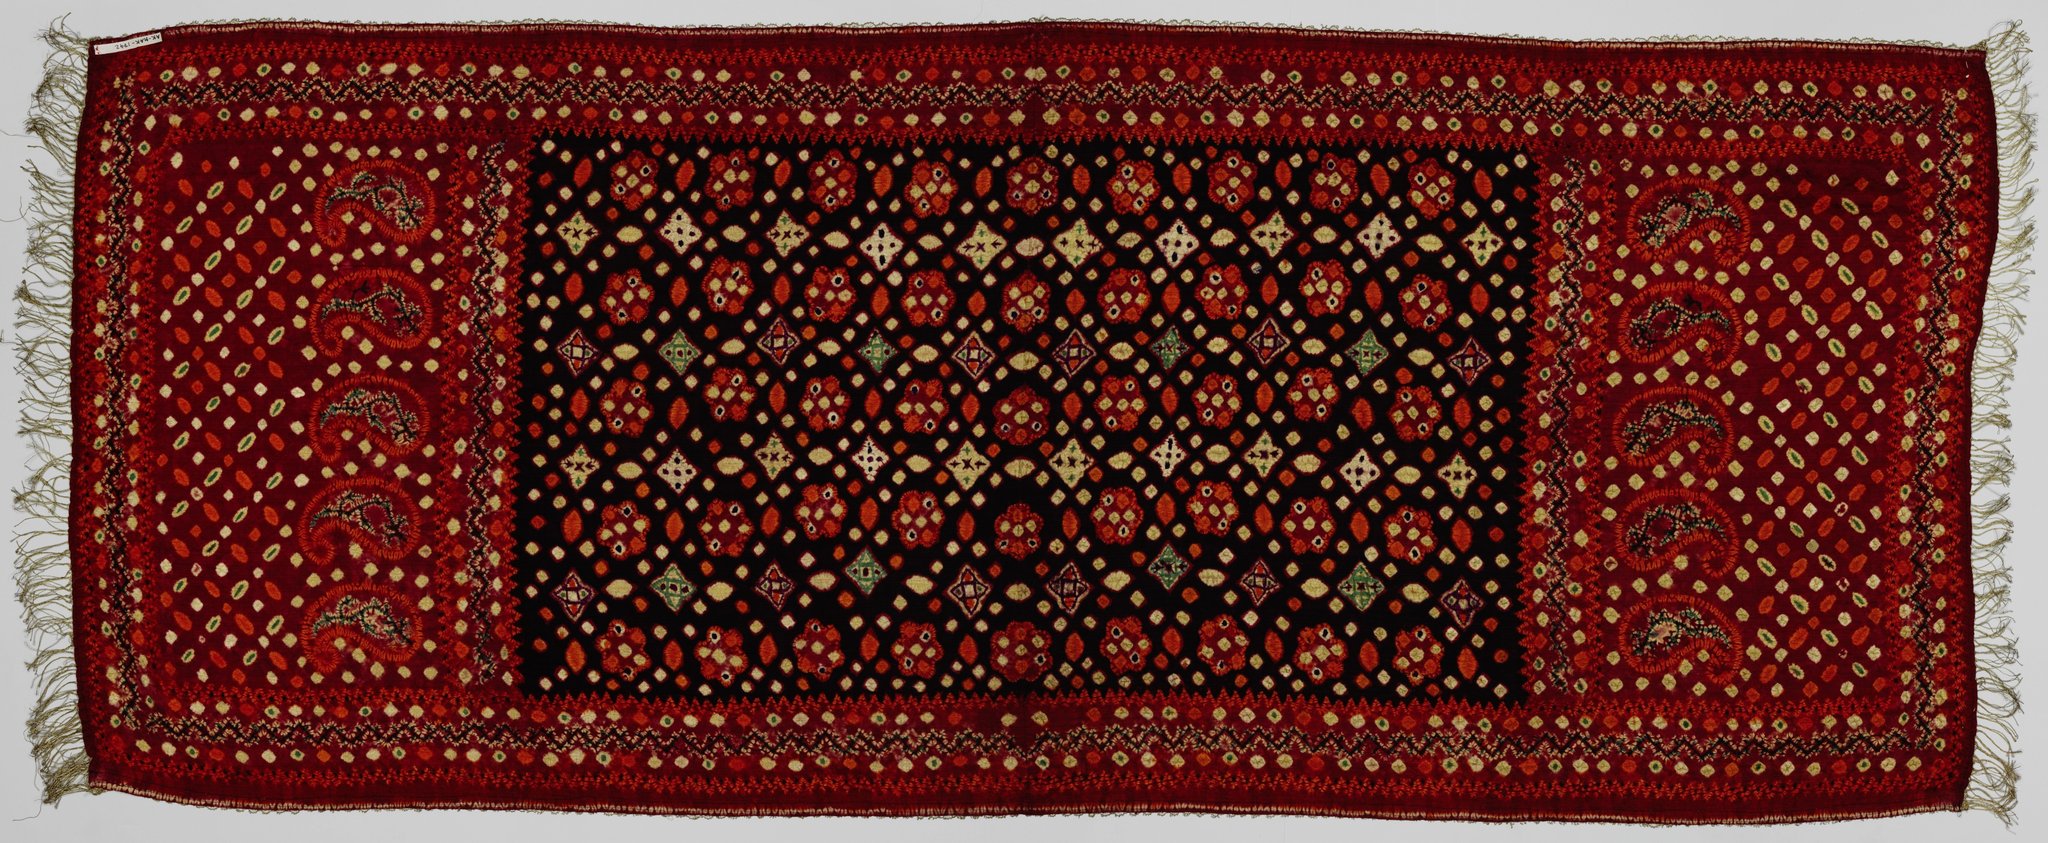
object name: schouderdoek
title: Kain pelangi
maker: Anonymous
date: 1900-1999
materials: gold thread, silk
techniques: tie dyed, weave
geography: south sumatra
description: Schouderdoek met florale en geometrische motieven.